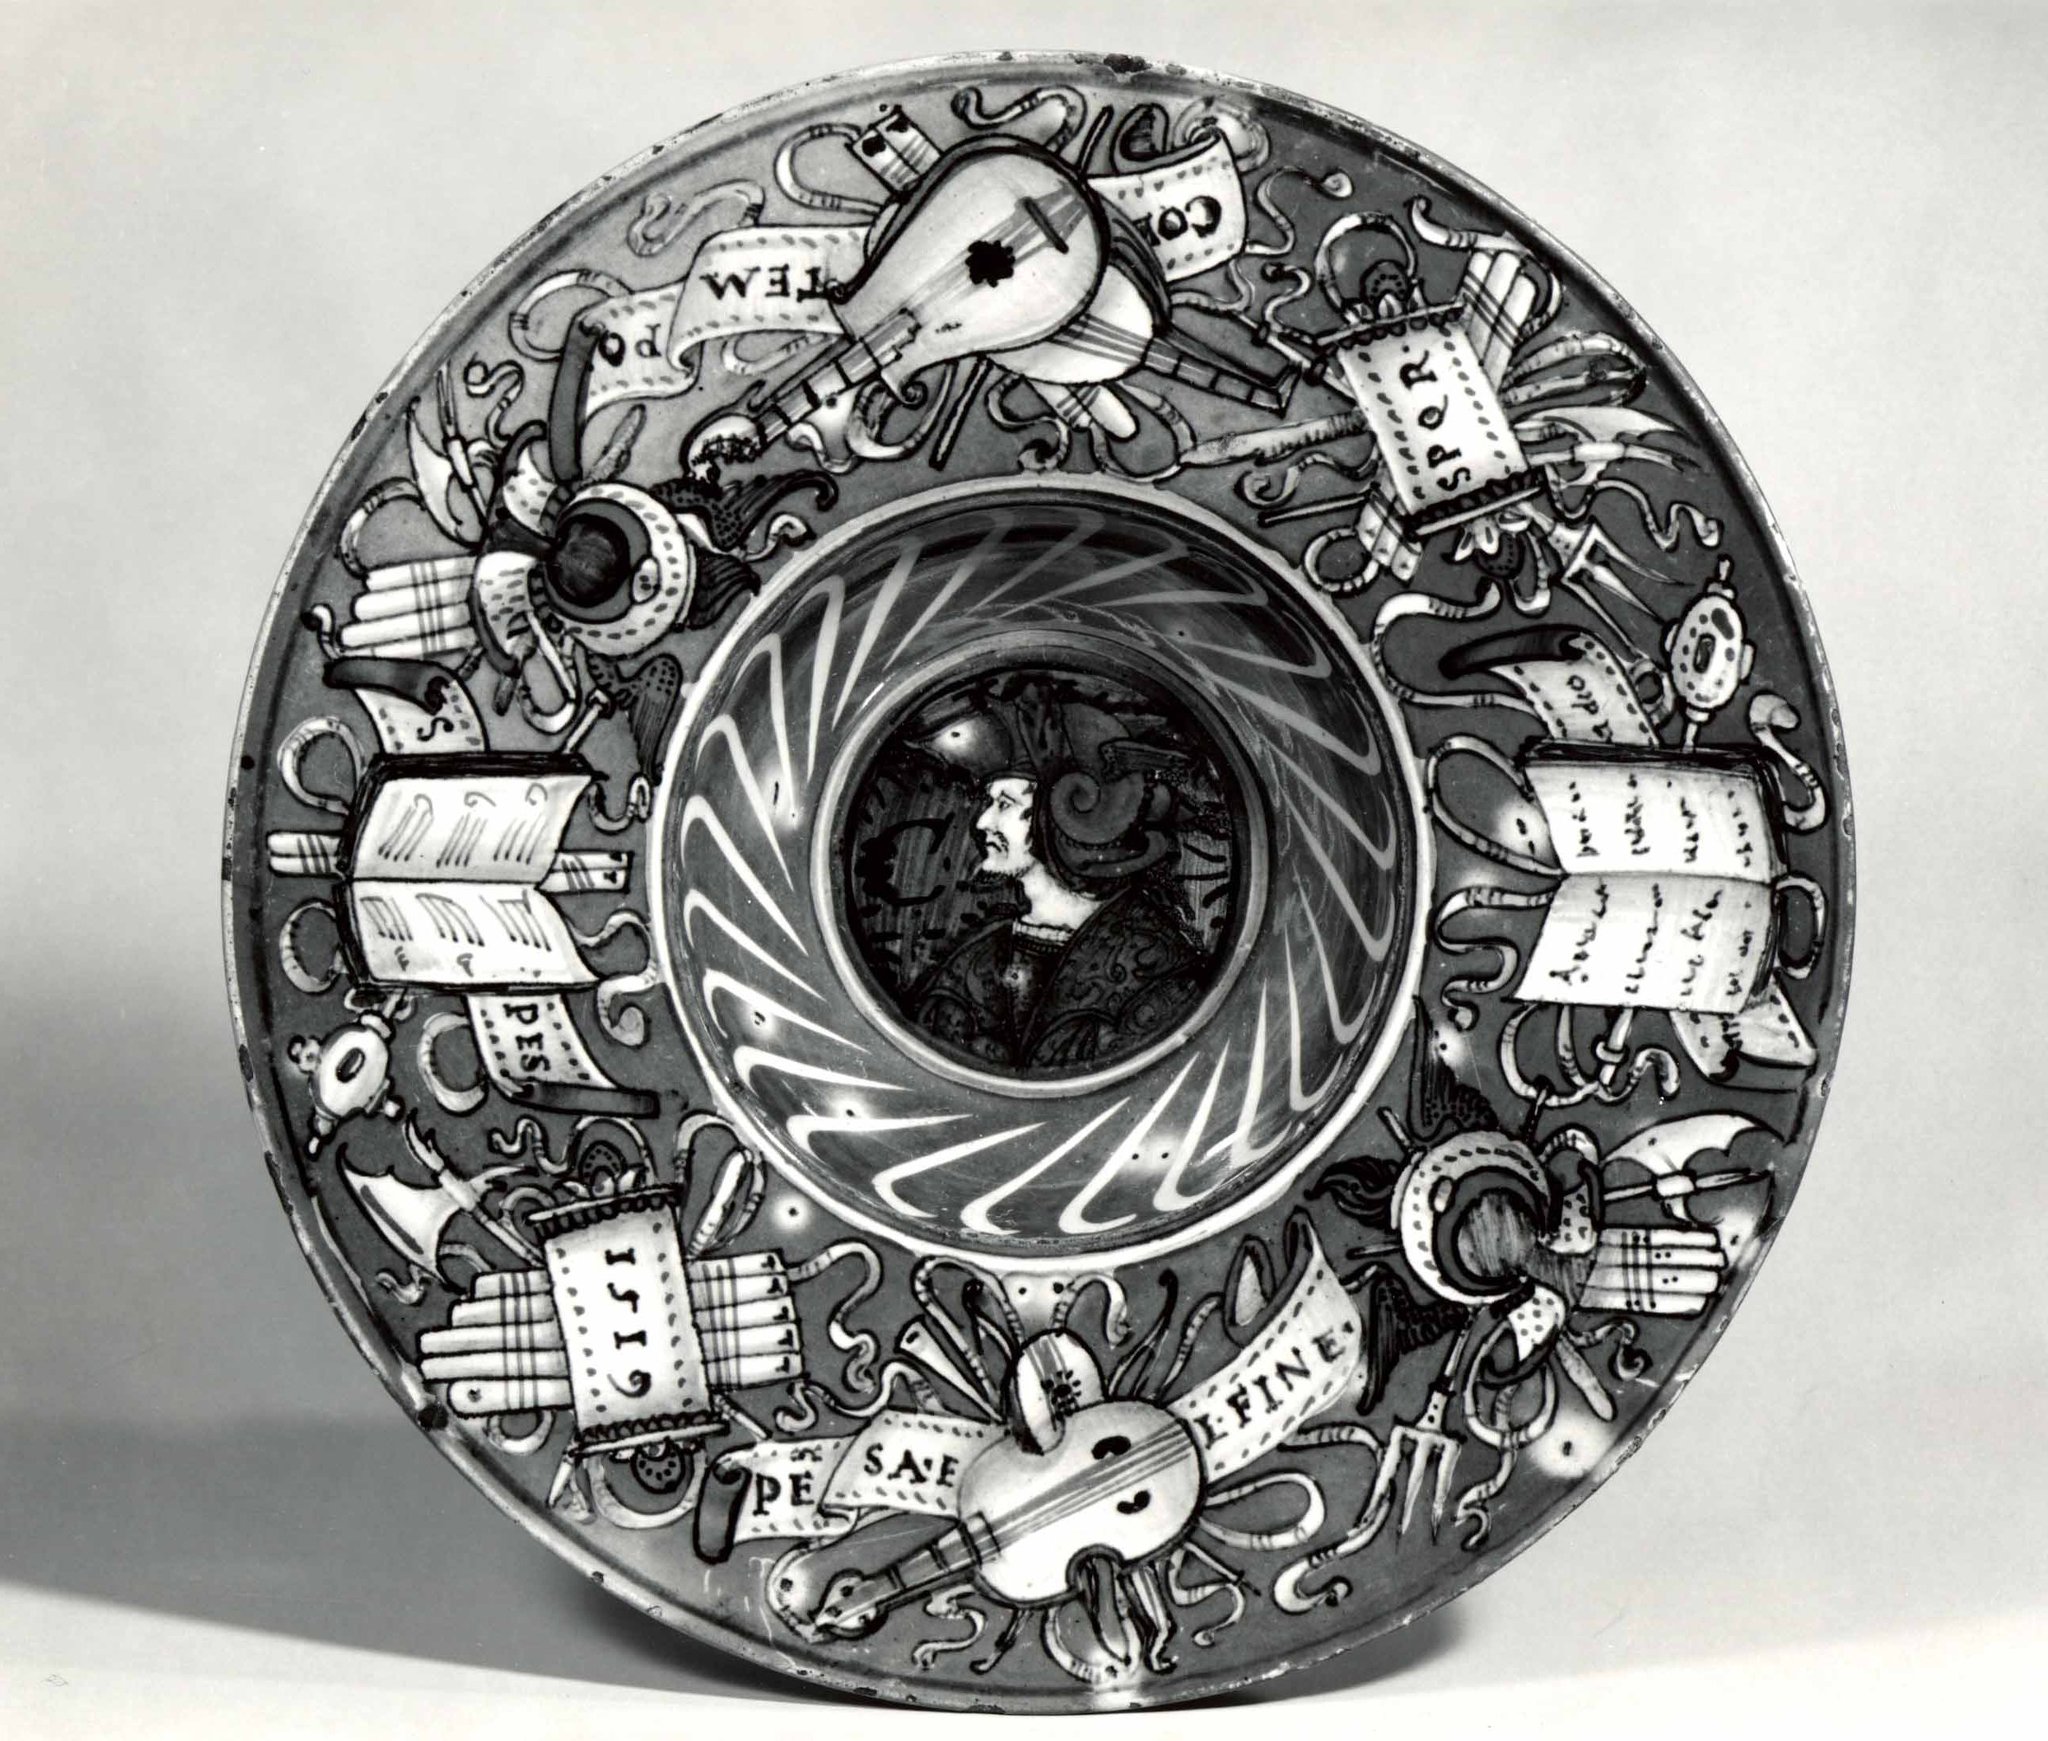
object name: plate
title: Plate (tondino)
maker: maestro giorgio andreoli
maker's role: artist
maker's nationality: italian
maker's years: 1500-1550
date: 1519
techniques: maiolica, glazing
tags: musical instruments,men,profiles